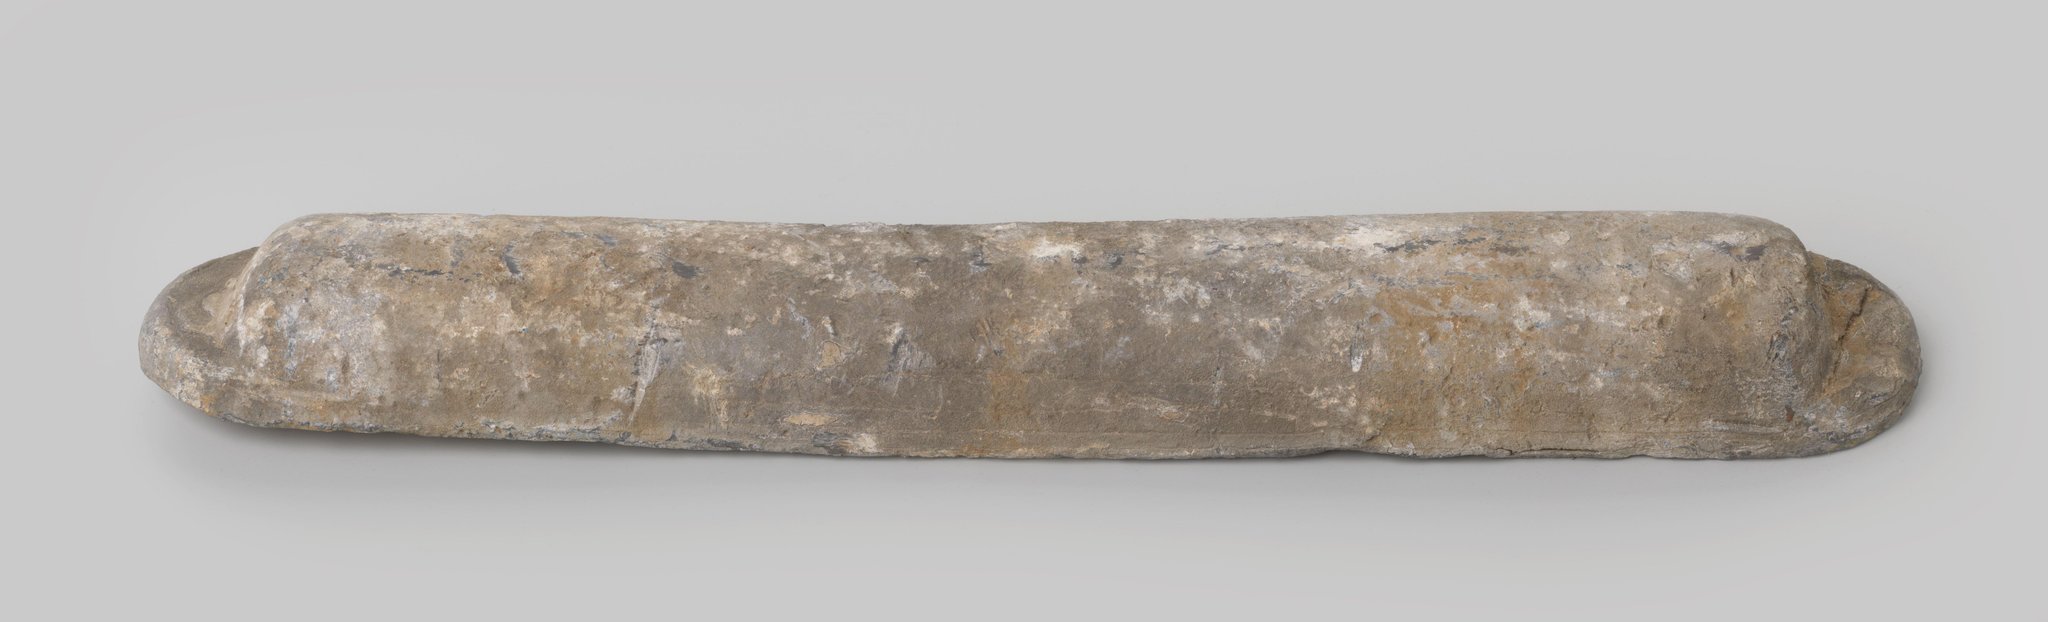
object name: ingot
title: Lead ingot used as ballast from the wreck of the Dutch East Indiaman Hollandia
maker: Anonymous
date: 1700-1743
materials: lead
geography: netherlands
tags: verenigde oostindische compagnie, hollandia (schip), annet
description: Ingot; (1) corroded, oblong, straight, flat upper side (91l, 15.8w, 6.8h), semicircular in section, semicircular stepped ends, on upper side marks legible [V,H,93].